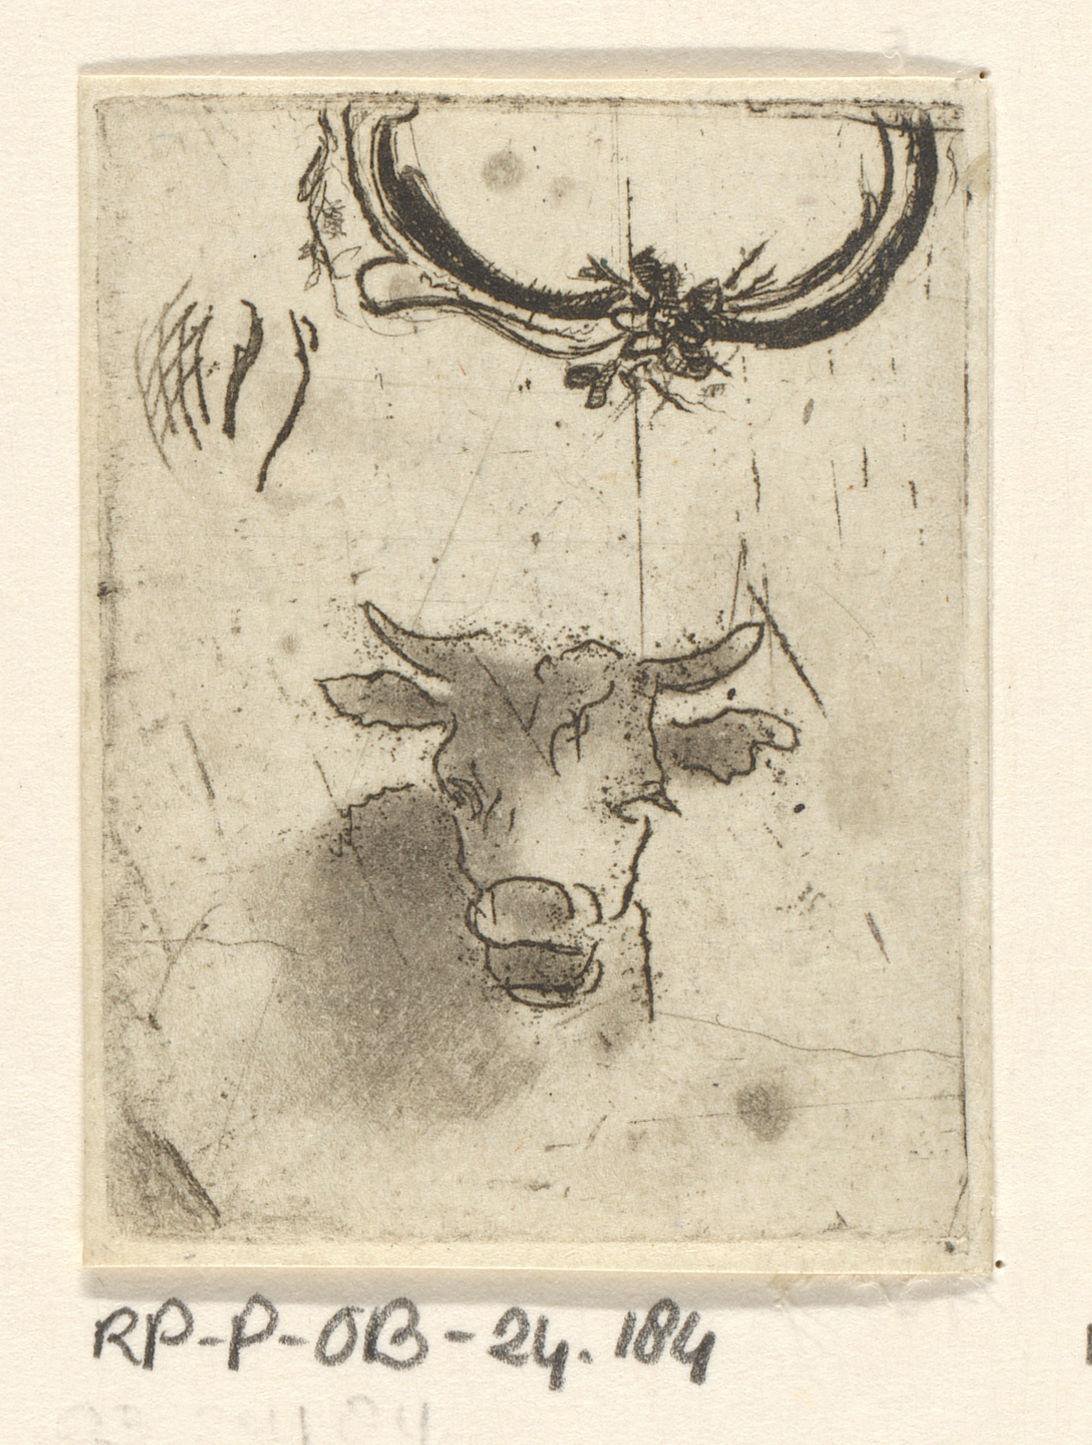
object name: print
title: Koeienkop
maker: jan van noort (1756-1837)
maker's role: painter, print maker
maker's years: 1756-1837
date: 1766-1837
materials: paper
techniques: aquatint, etching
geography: leiden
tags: cow, ornament ~ cartouche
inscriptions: collector's mark: Lugt 2228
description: Koeienkop met daarboven een ornamenteel cartouche.